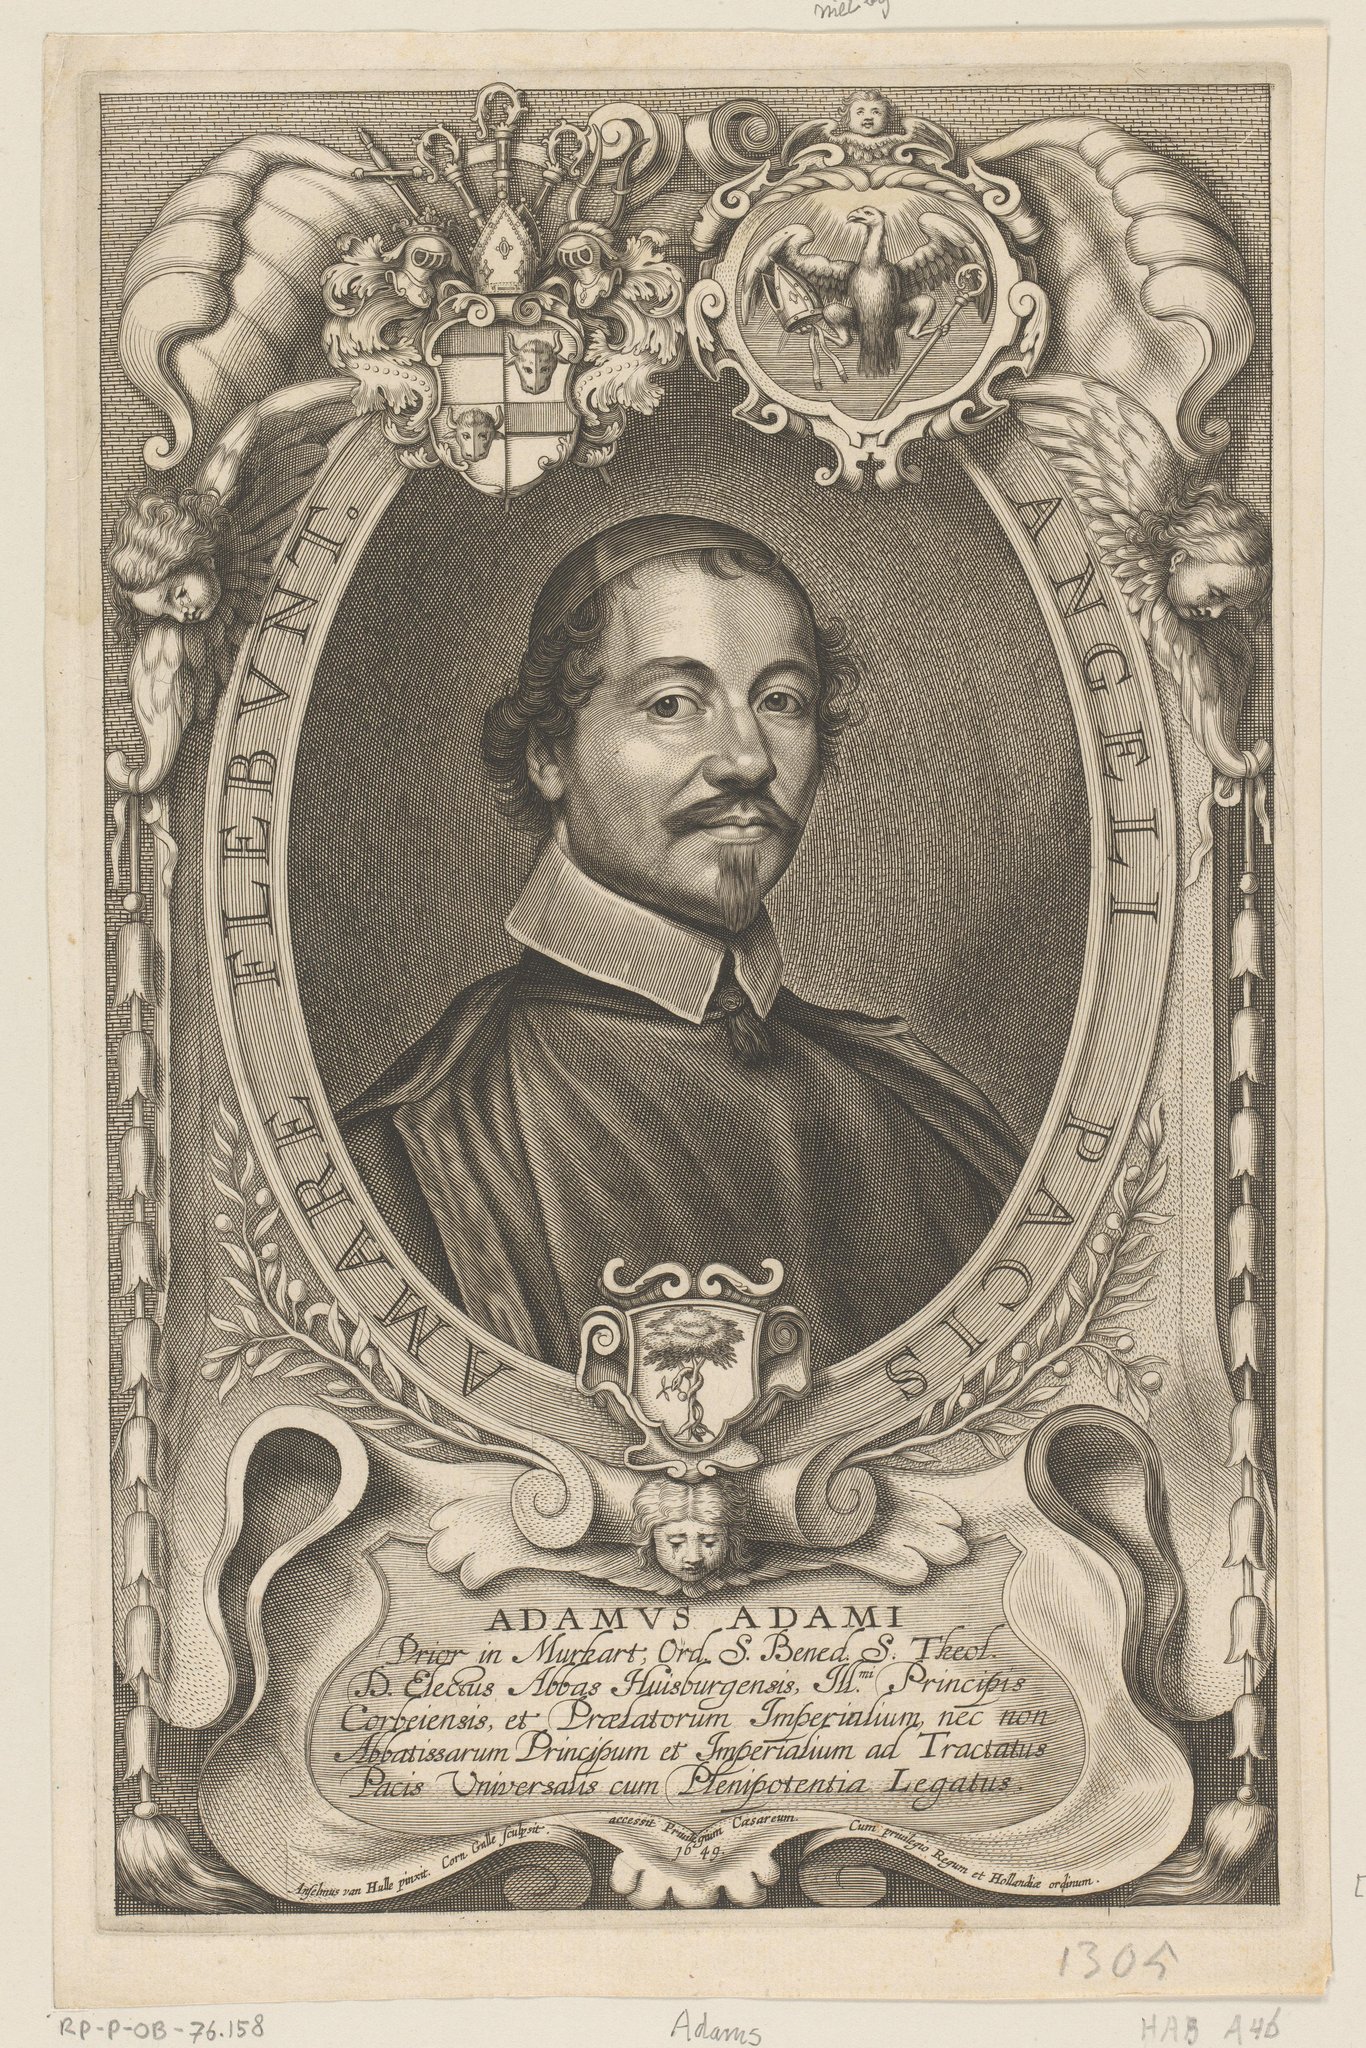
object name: print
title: Portret van Adam Adami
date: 1649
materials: paper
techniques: engraving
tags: archbishop, bishop, etc. (roman catholic), historical persons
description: Prent is gebruikt in verschillende series. De huidige staat is gebruikt in de hieronder vermelde serie en uitgaven (1), (2), (3) en mogelijk ook (4) en (5). (1)‘Legati Celeberrimi’, uitgegeven door Daniel Middeler in 1648 in Antwerpen. (2)‘Legati Celeberrimi’, waarschijnlijk uitgegeven in 1651, maar opnieuw met de vermelding door Daniel Middeler in 1648 in Antwerpen. (3)‘Legati Celeberrimi', waarschijnlijk uitgegeven in 1658, maar opnieuw met de vermelding door Daniel Middeler in 1648 in Antwerpen. (4) 'Pacificatores orbis Christiani, sive icones principum, ducum et legatorum, qui Monasterii atque Osnabrugae (...)', uitgegeven door Pieter van der Slaart in 1696 in Rotterdam. (5) 'Pacificatores orbis Christiani, sive icones principum, ducum et legatorum, qui Monasterii atque Osnabrugae (...)', uitgegeven door Pieter van der Slaart in 1697 in Rotterdam. (6) 'Pacificatores orbis Christiani, sive icones principum, ducum et legatorum, qui Monasterii atque Osnabrugae (...)', waarschijnlijk uitgegeven circa 1713, maar opnieuw met vermelding van Pieter van der Slaart in 1697 in Rotterdam. De platen in deze uitgave zijn voor het eerst genummerd. (7) 'Les hommes illustres qui ont vécu dans le XXIIe siècle (...)', uitgegeven door David Mortier in 1717 in Rotterdam. Zie documentatie. Mogelijk zijn er nog meerdere uitgaven en staten van deze prent.